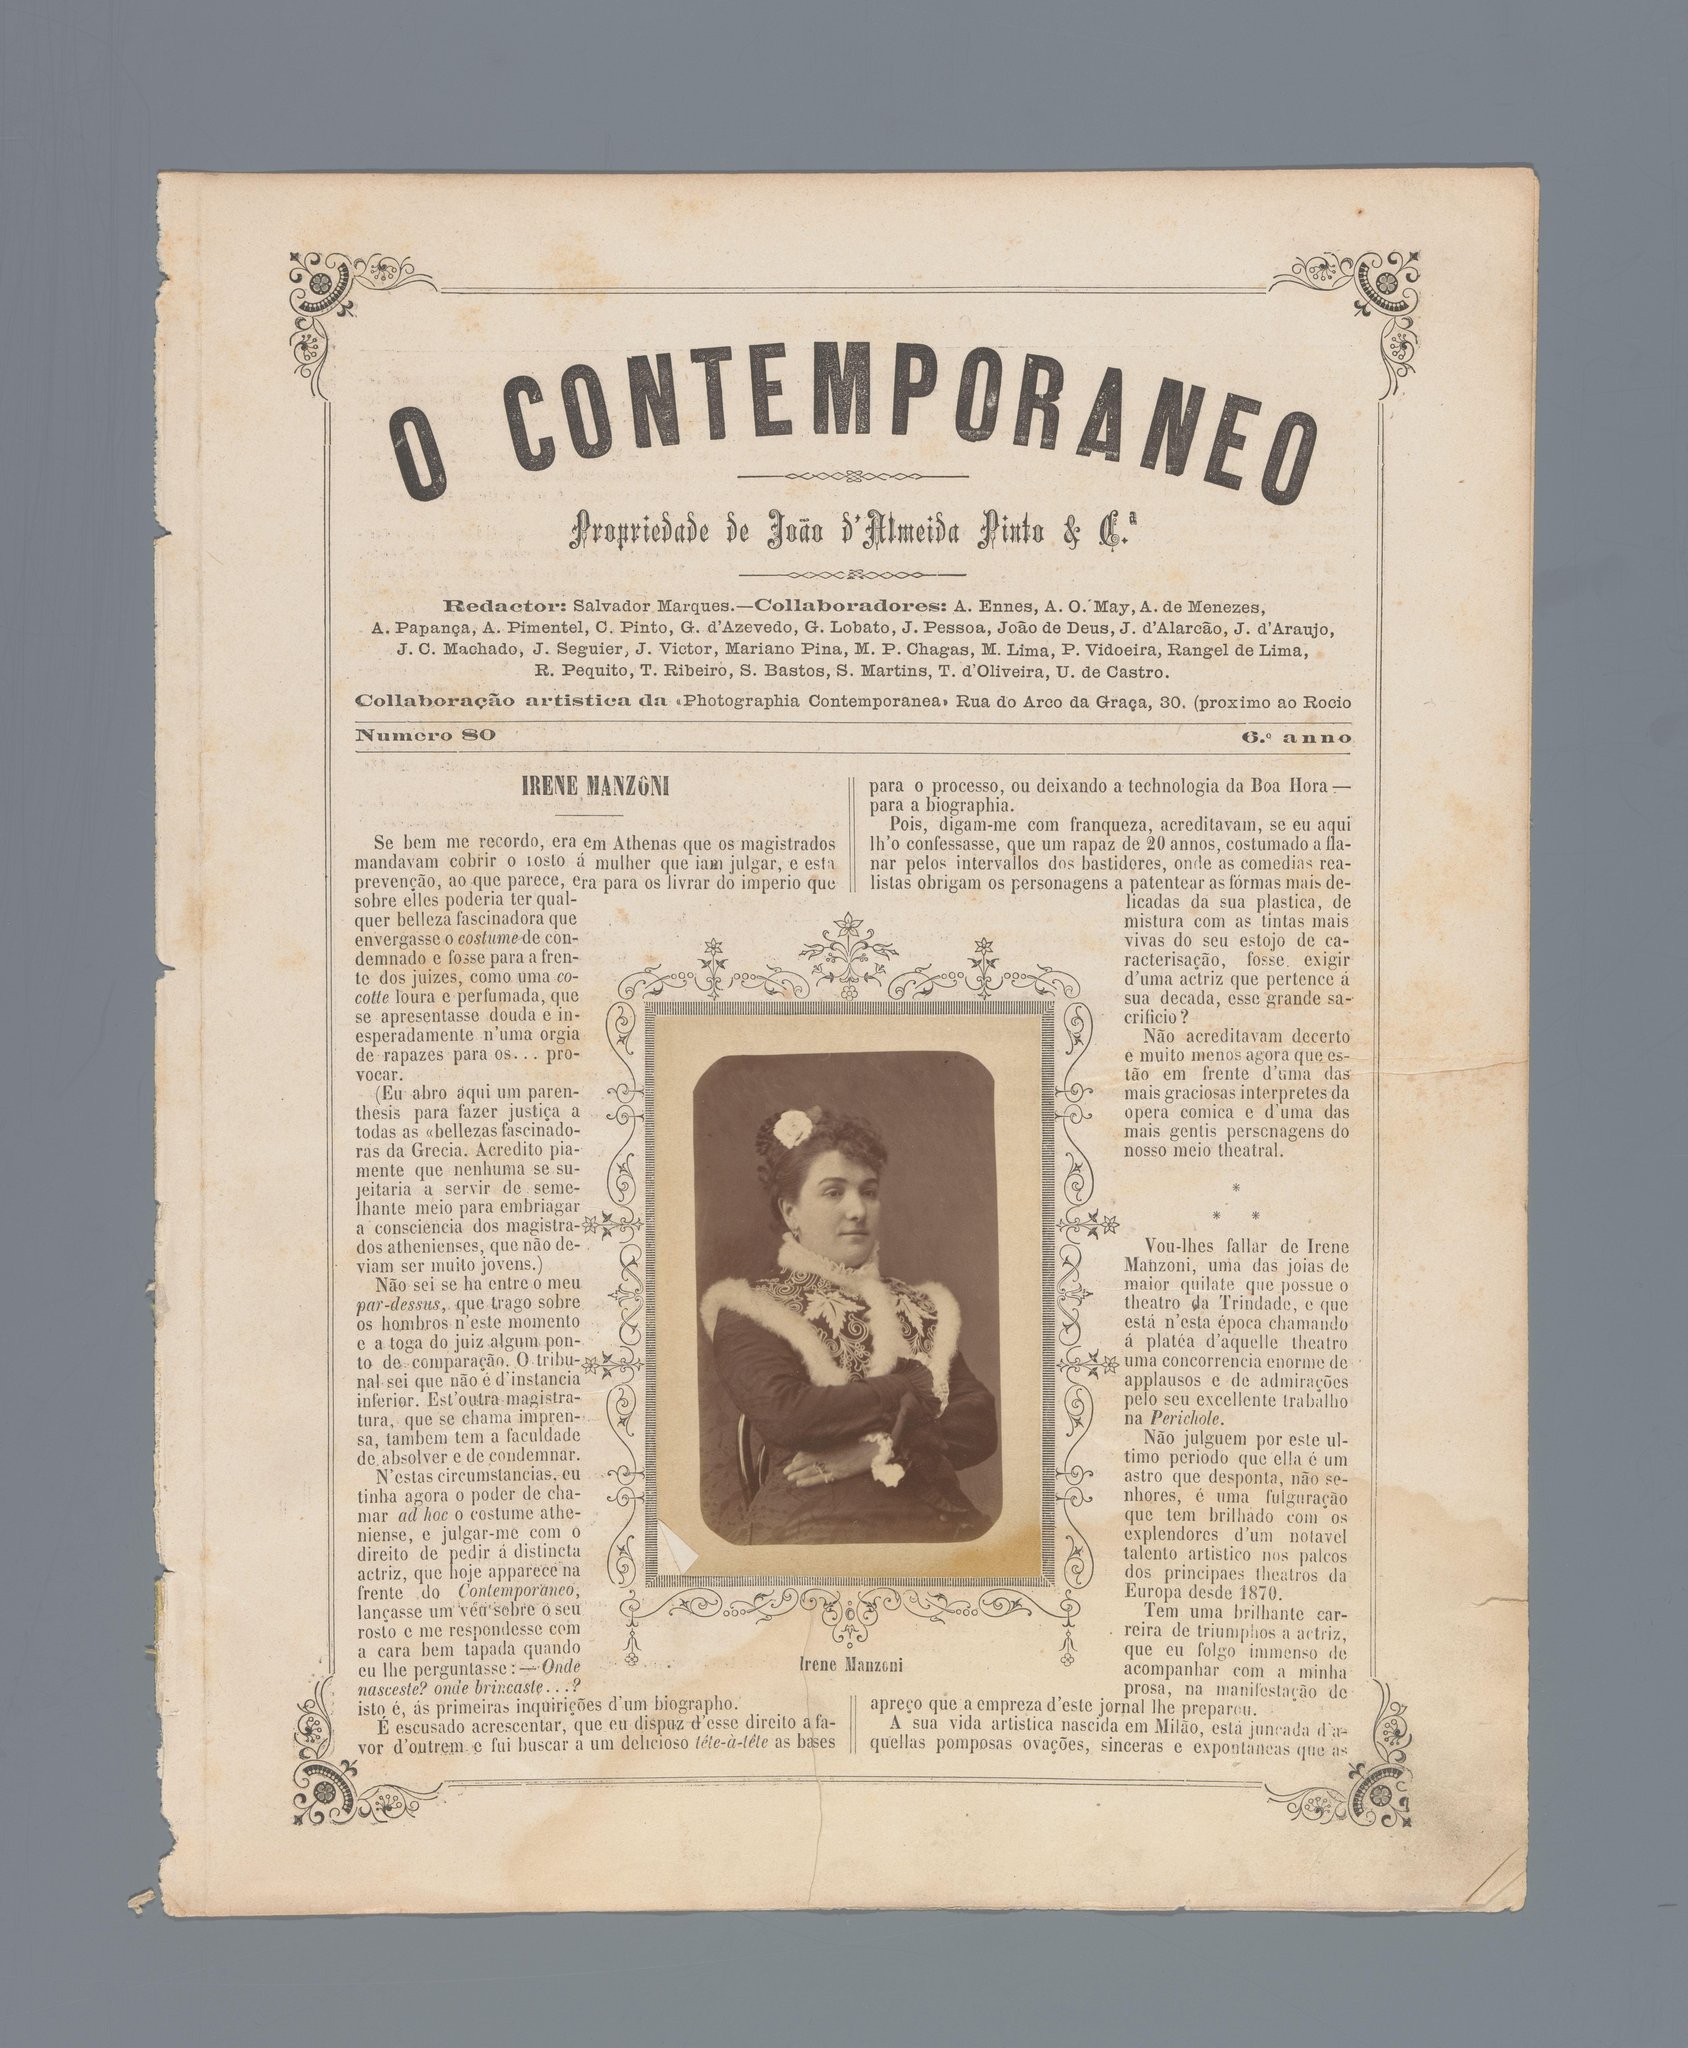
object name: photograph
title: O contemporaneo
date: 1875-1880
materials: paper, photographic support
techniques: albumen print, printing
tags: historical persons - bb - woman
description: Op de voorpagina bevindt zich een portret van Irene Manzoni.